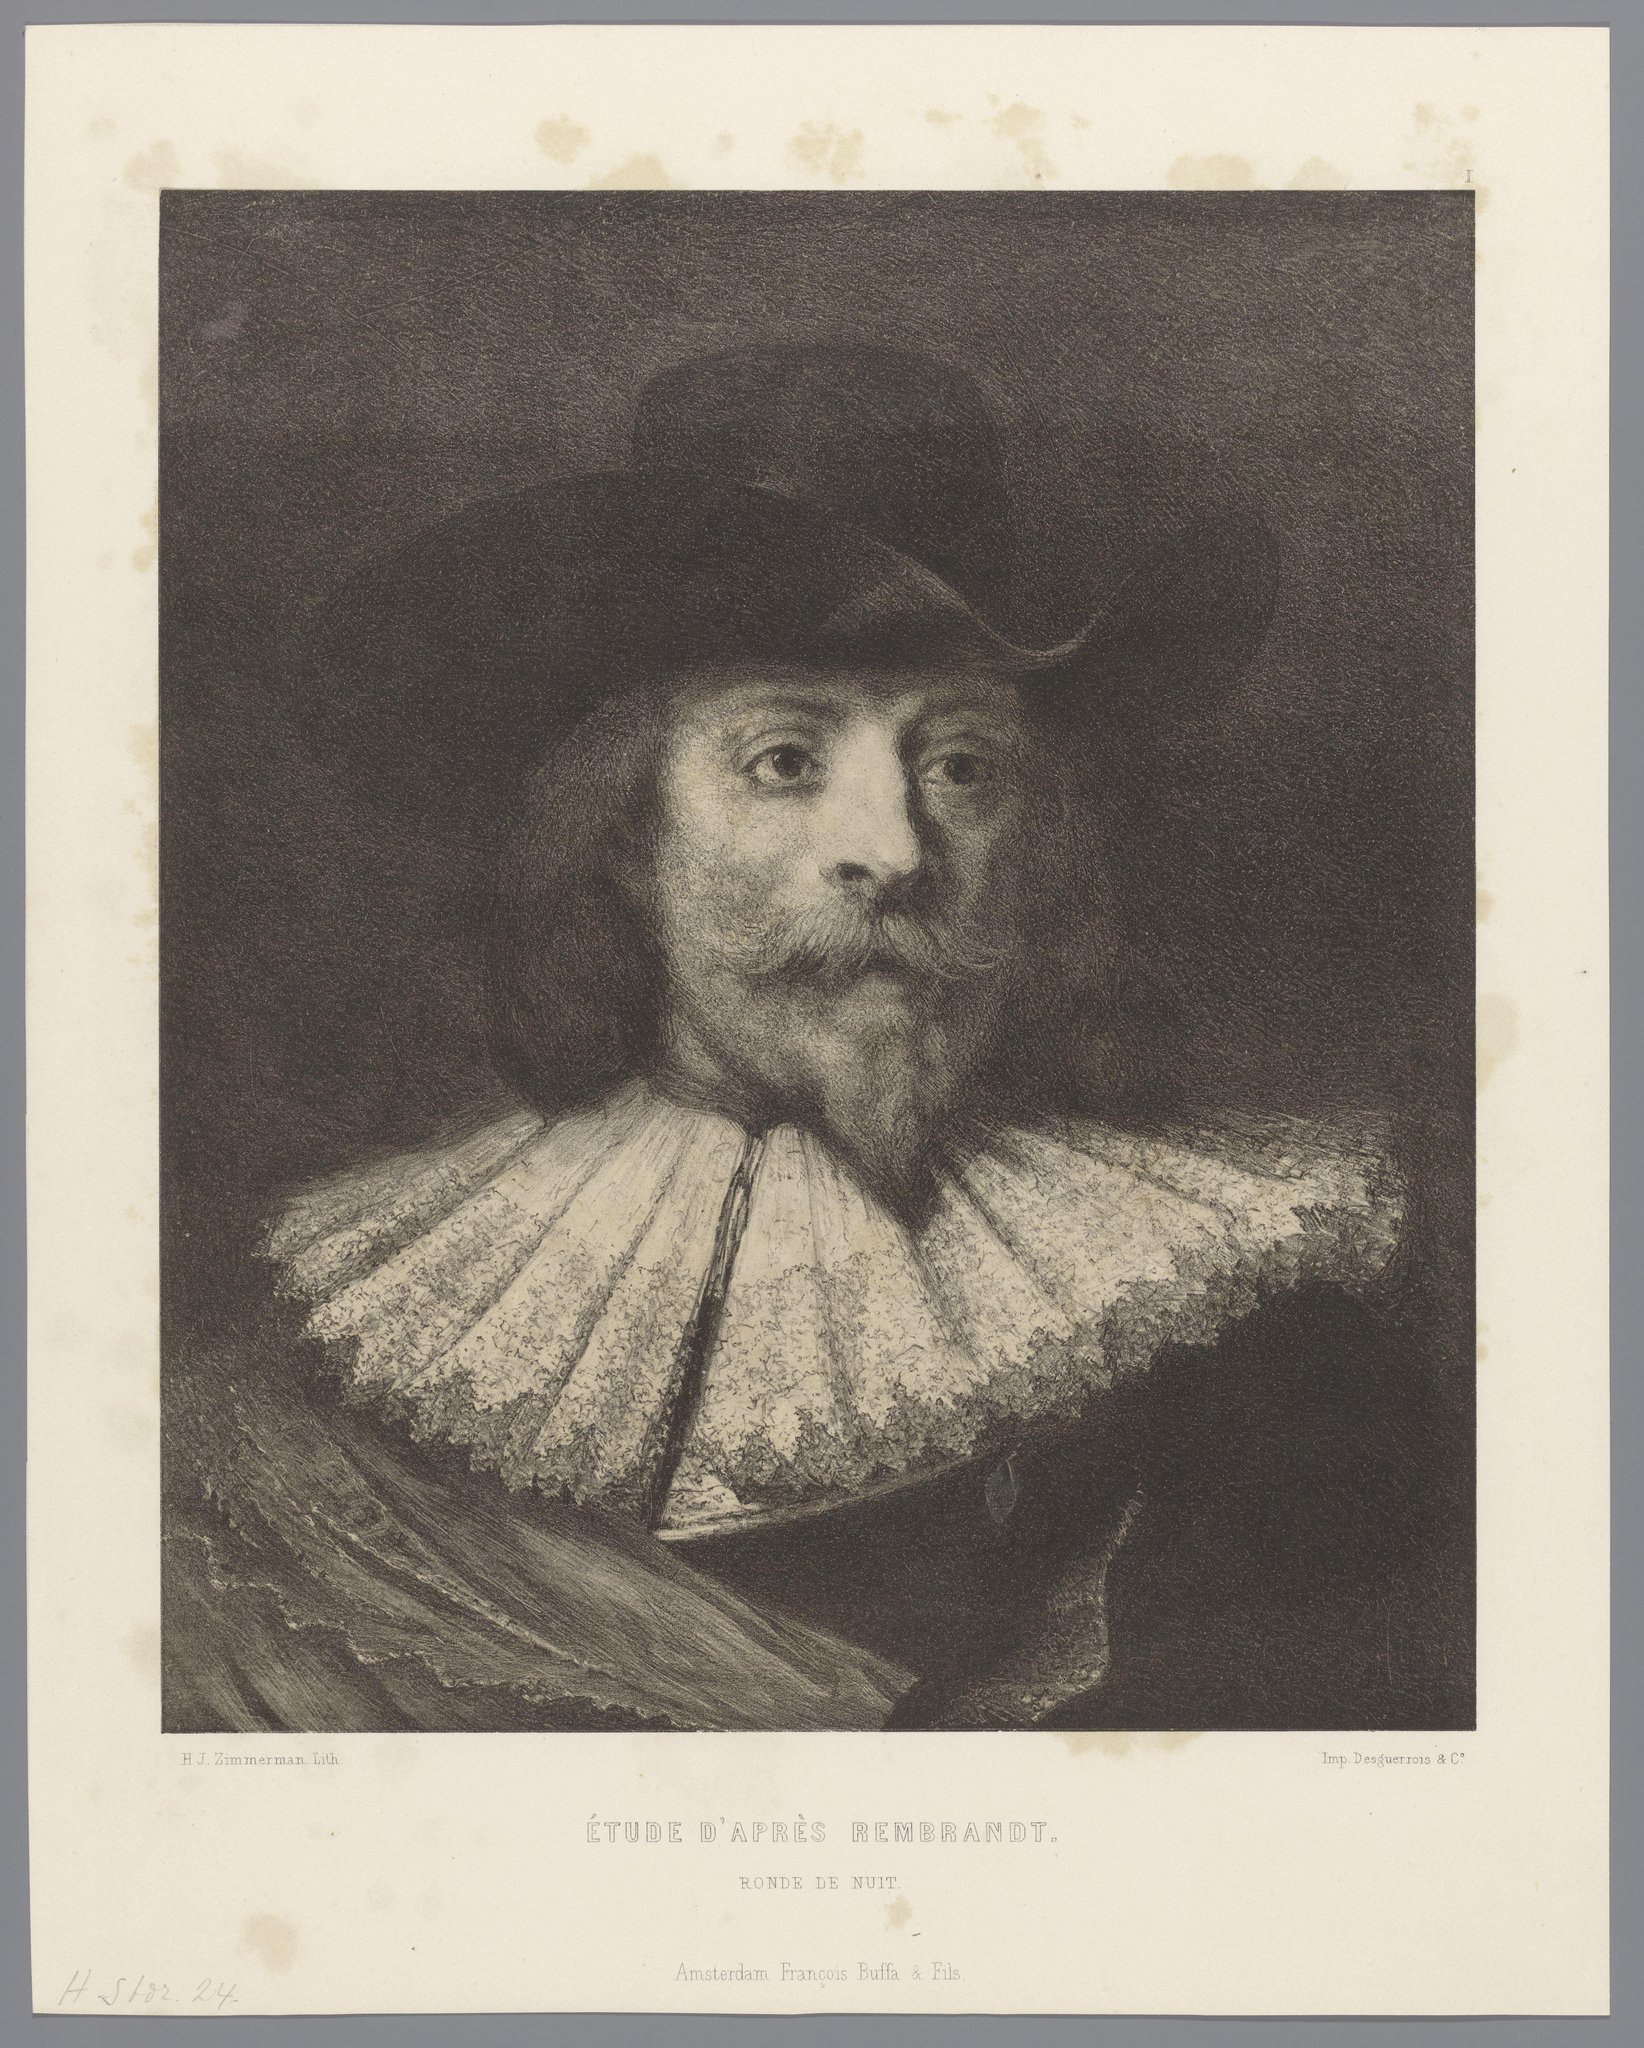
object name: print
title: Etudes d`après Rembrandt et autres maîtres hollandais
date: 1859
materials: paper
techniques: lithograph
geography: amsterdam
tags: leiden, amsterdam, painter, print maker, draughtsman, rembrandt van rijn, picture, painting, historical persons (+ (full) bust portrait)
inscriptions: collector's mark: Lugt 2760, collector's mark: Lugt 2228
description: Detail uit Het korporaalschap van kapitein Frans Banning Cocq door Rembrandt. Deze prent maakt deel uit van een omslag met zeven prenten.